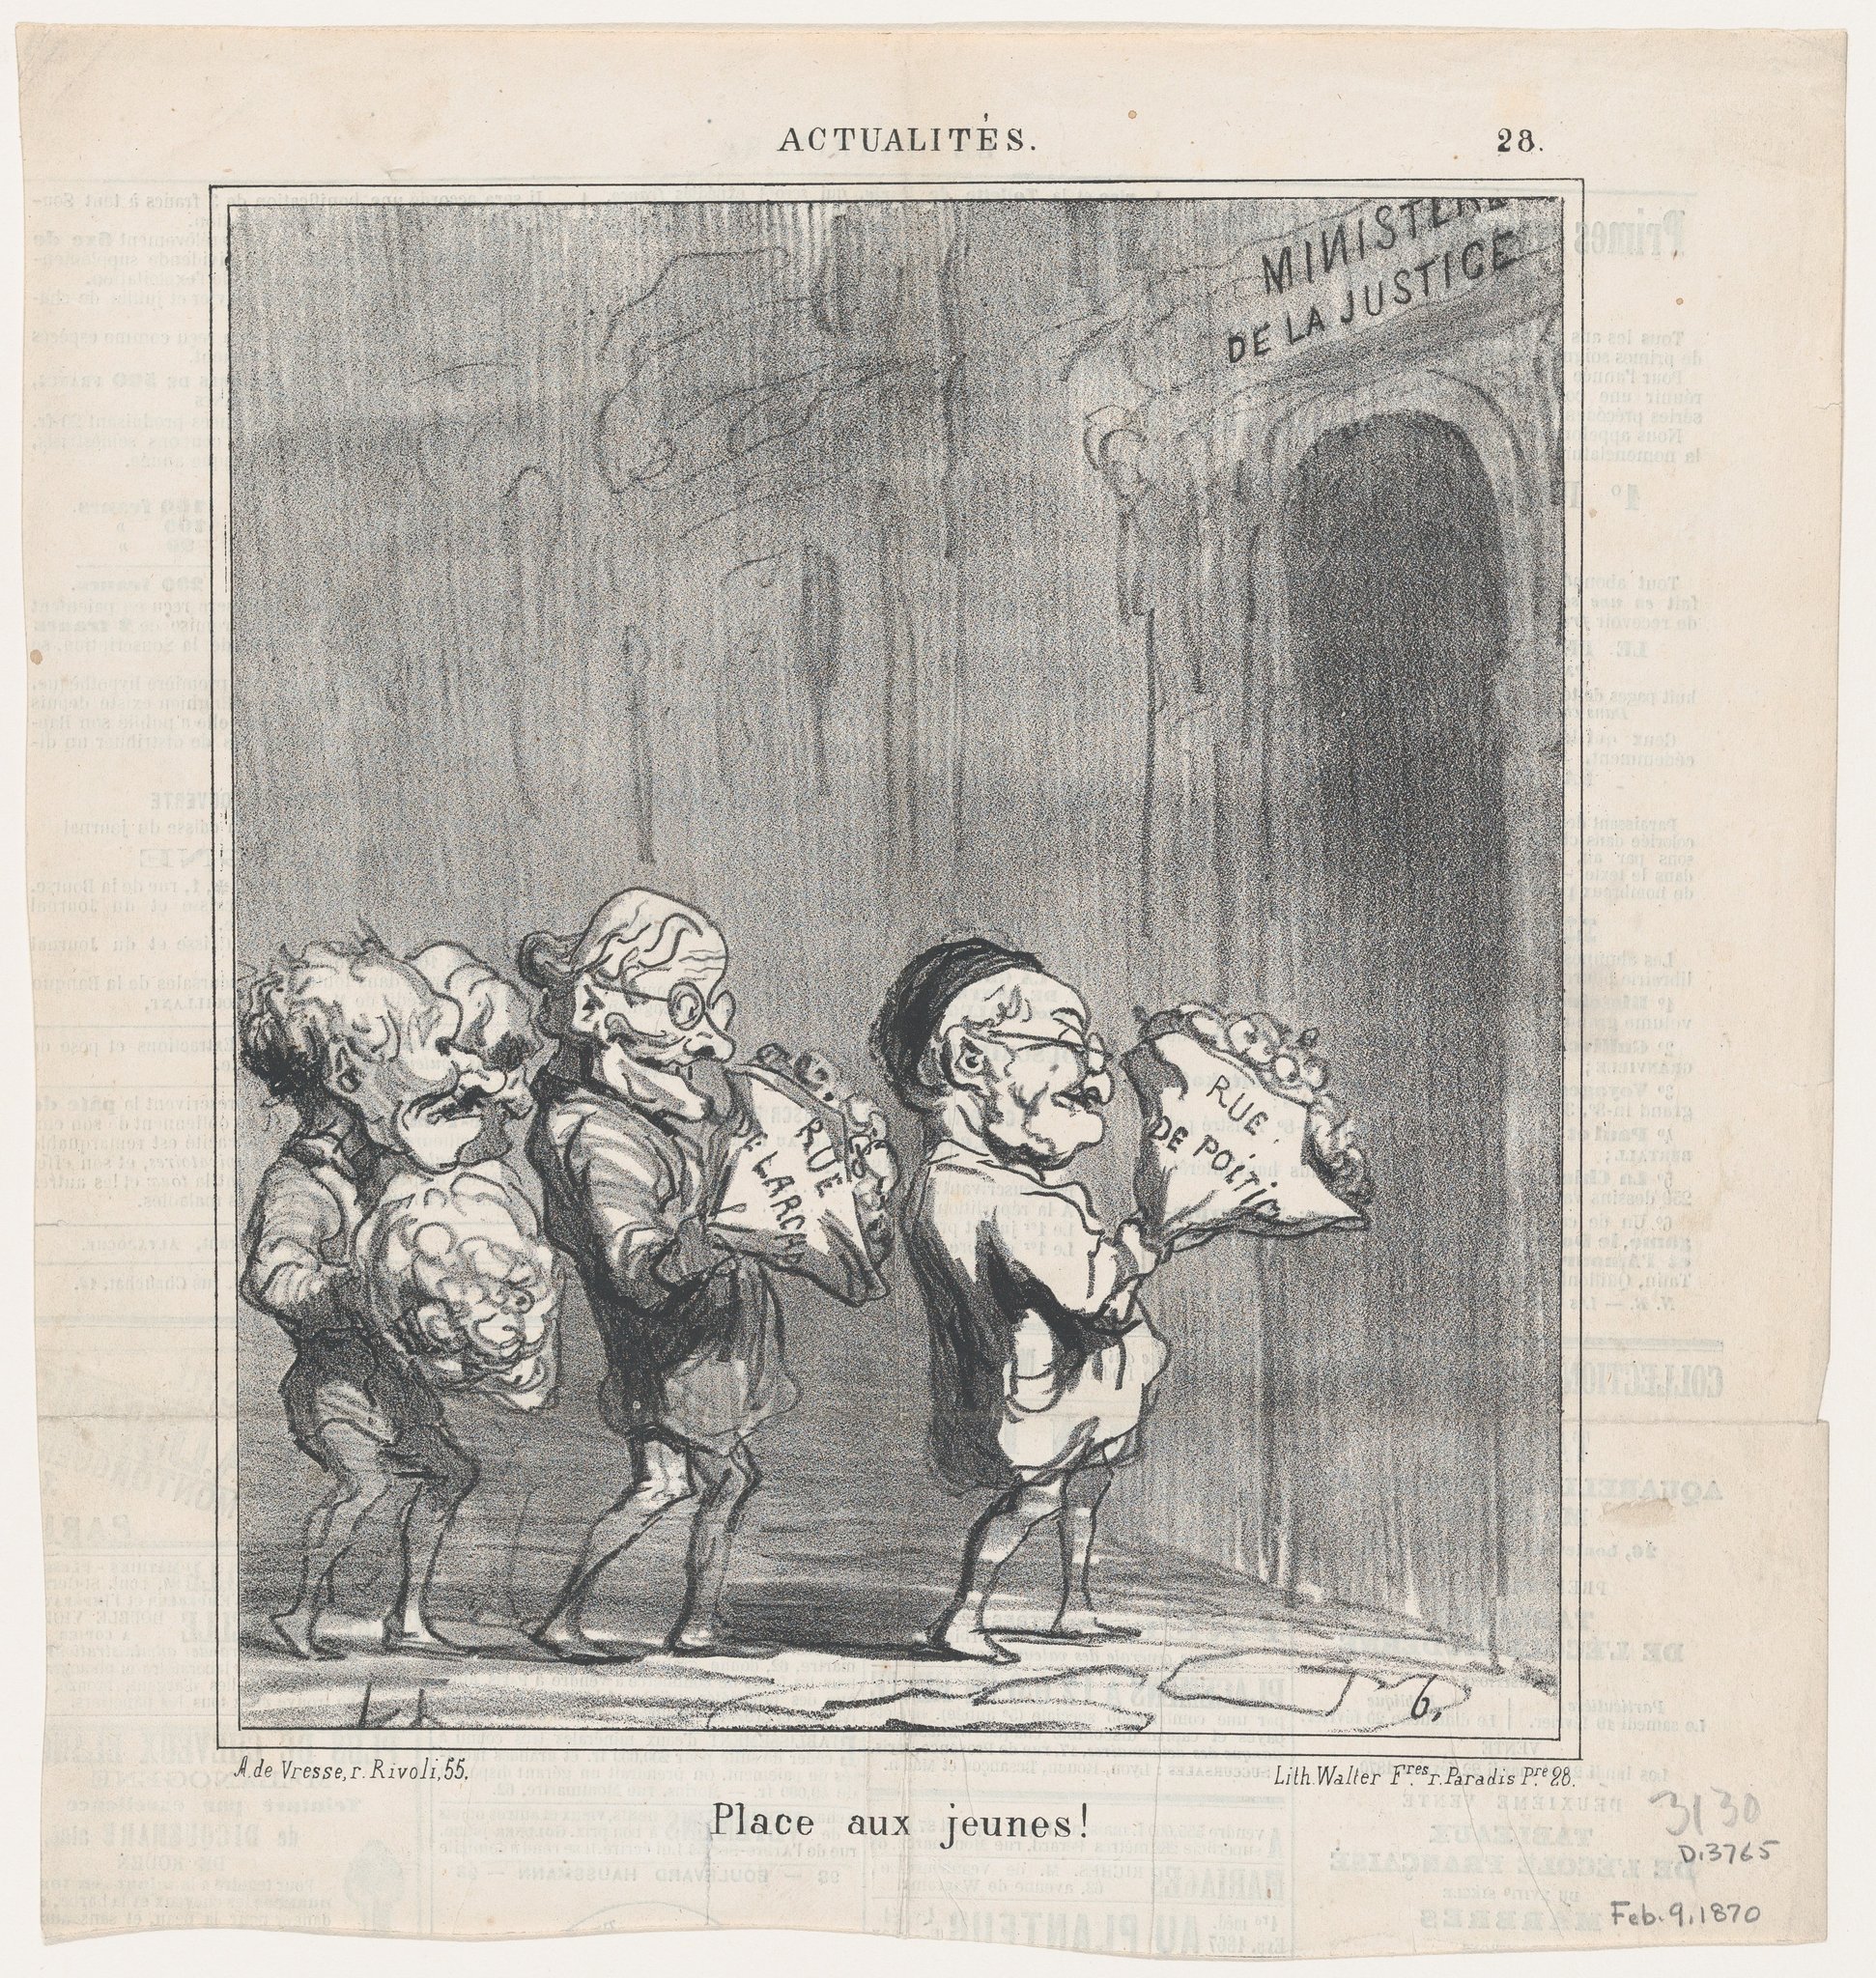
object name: print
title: Make room for the young!, from 'News of the day,' published in Le Charivari, February 9, 1870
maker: honoré daumier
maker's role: artist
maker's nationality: french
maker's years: 1808-1879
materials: paper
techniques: lithograph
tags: satire,men